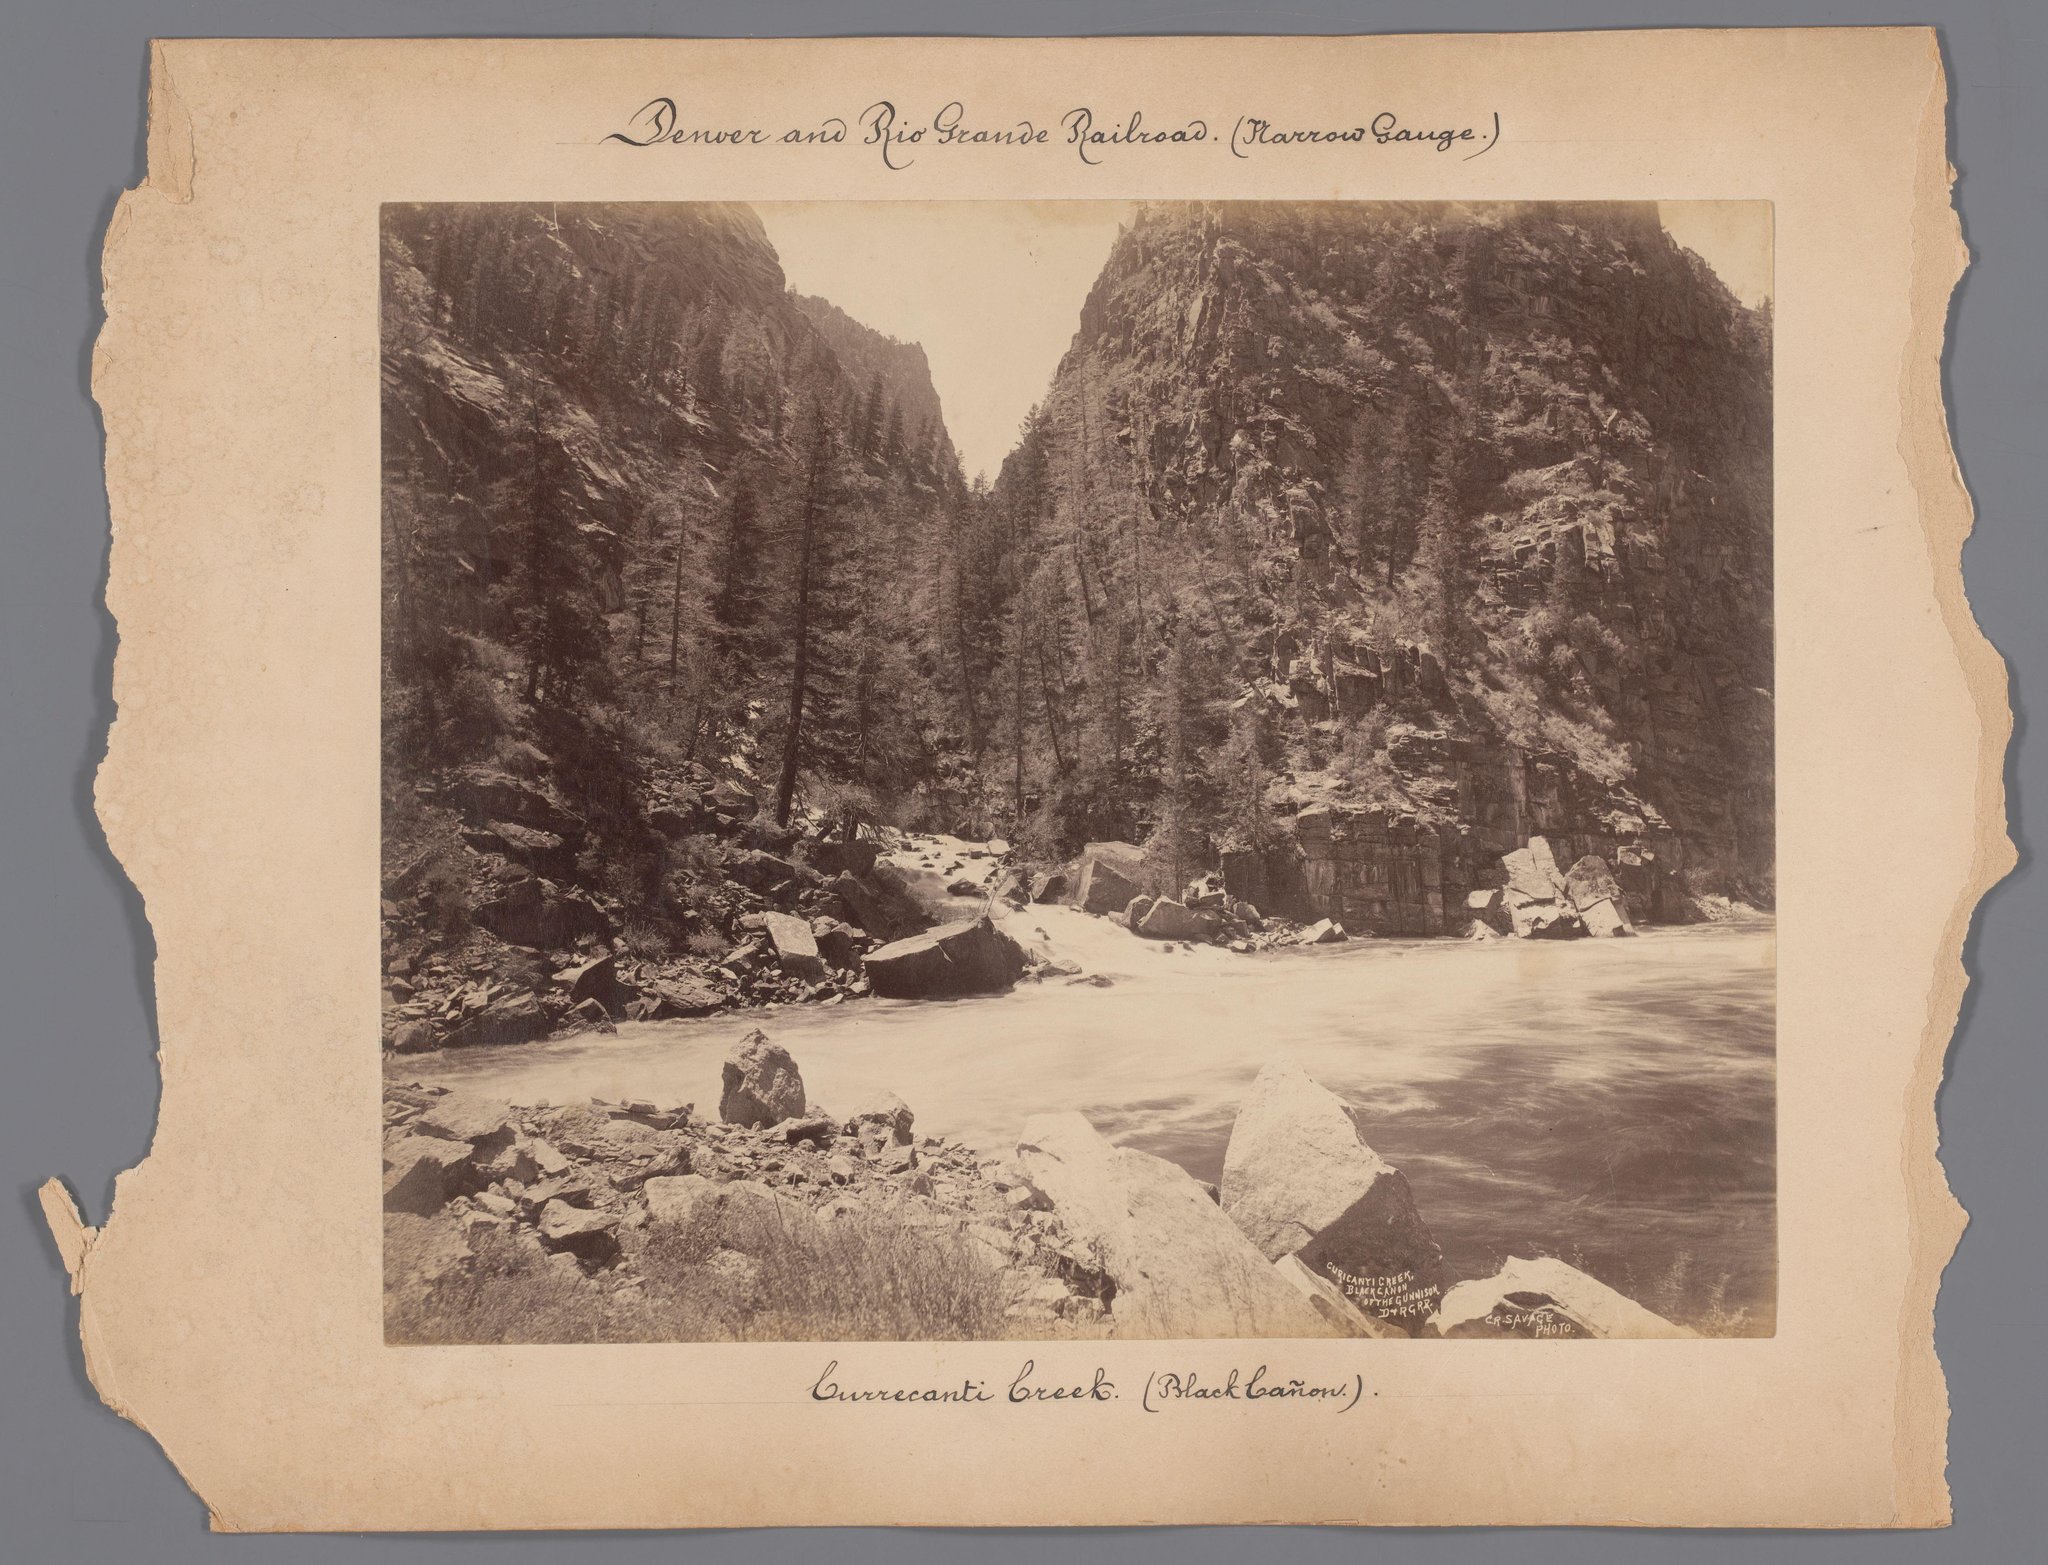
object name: photograph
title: Curecanti Creek in Black Can[y]on Gunnison National Park, Colorado, Verenigde Staten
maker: charles roscoe savage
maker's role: fotograaf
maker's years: 1832-1909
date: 1880-1900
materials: cardboard, photographic support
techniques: albumen print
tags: colorado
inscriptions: inscription: ‘[...?]ande Railroad. (Narrow Gauge)//Currecanti [sic] Needle. (Black Cañon)’, inscription: ‘Curicanyi [sic] Creek.//Black Canon of the Gunnison//D+RGRR [?].’, caption: ‘Currecanti [sic] Creek (Black Cañon [sic])’, inscription: ‘Denver and Rio Grande Railroad (Narrow Gauge)’, inscription: ‘CR SAVAGE PHOTO.’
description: Curecanti National Recreation Area en Black Can[y]on of the Gunnison National Park zijn Nationale Parken in het western van Colorado.